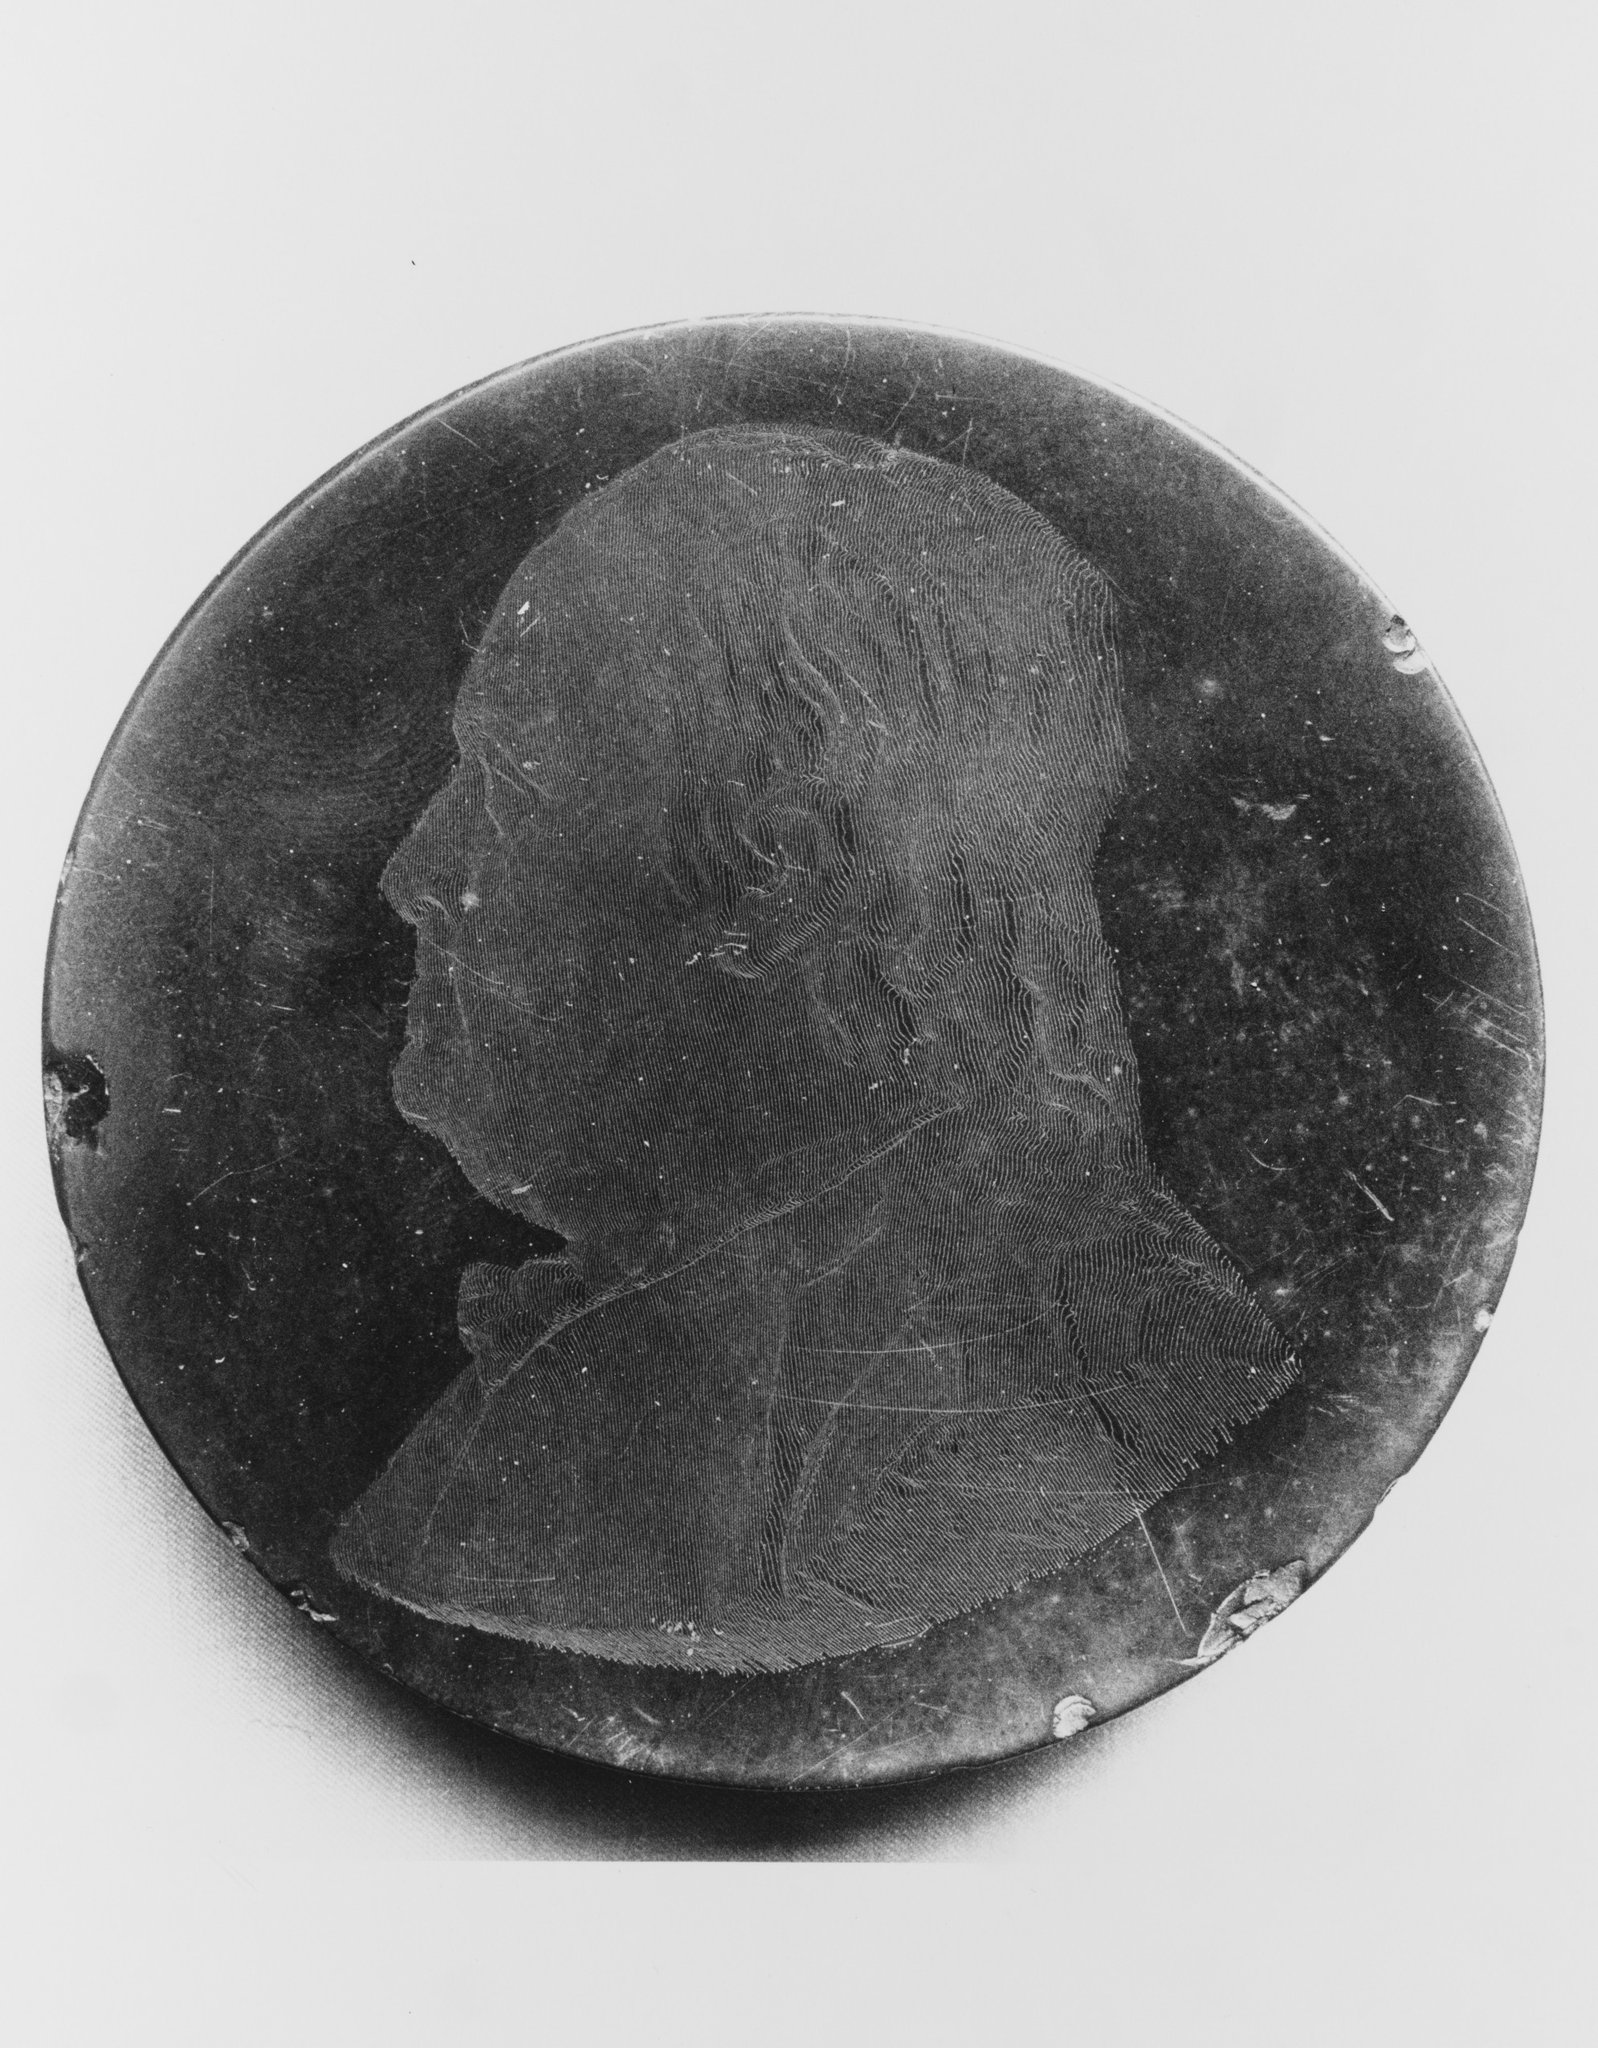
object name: bust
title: Portrait Bust of Benjamin Franklin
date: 1800-1883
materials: stone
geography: france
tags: benjamin franklin,profiles